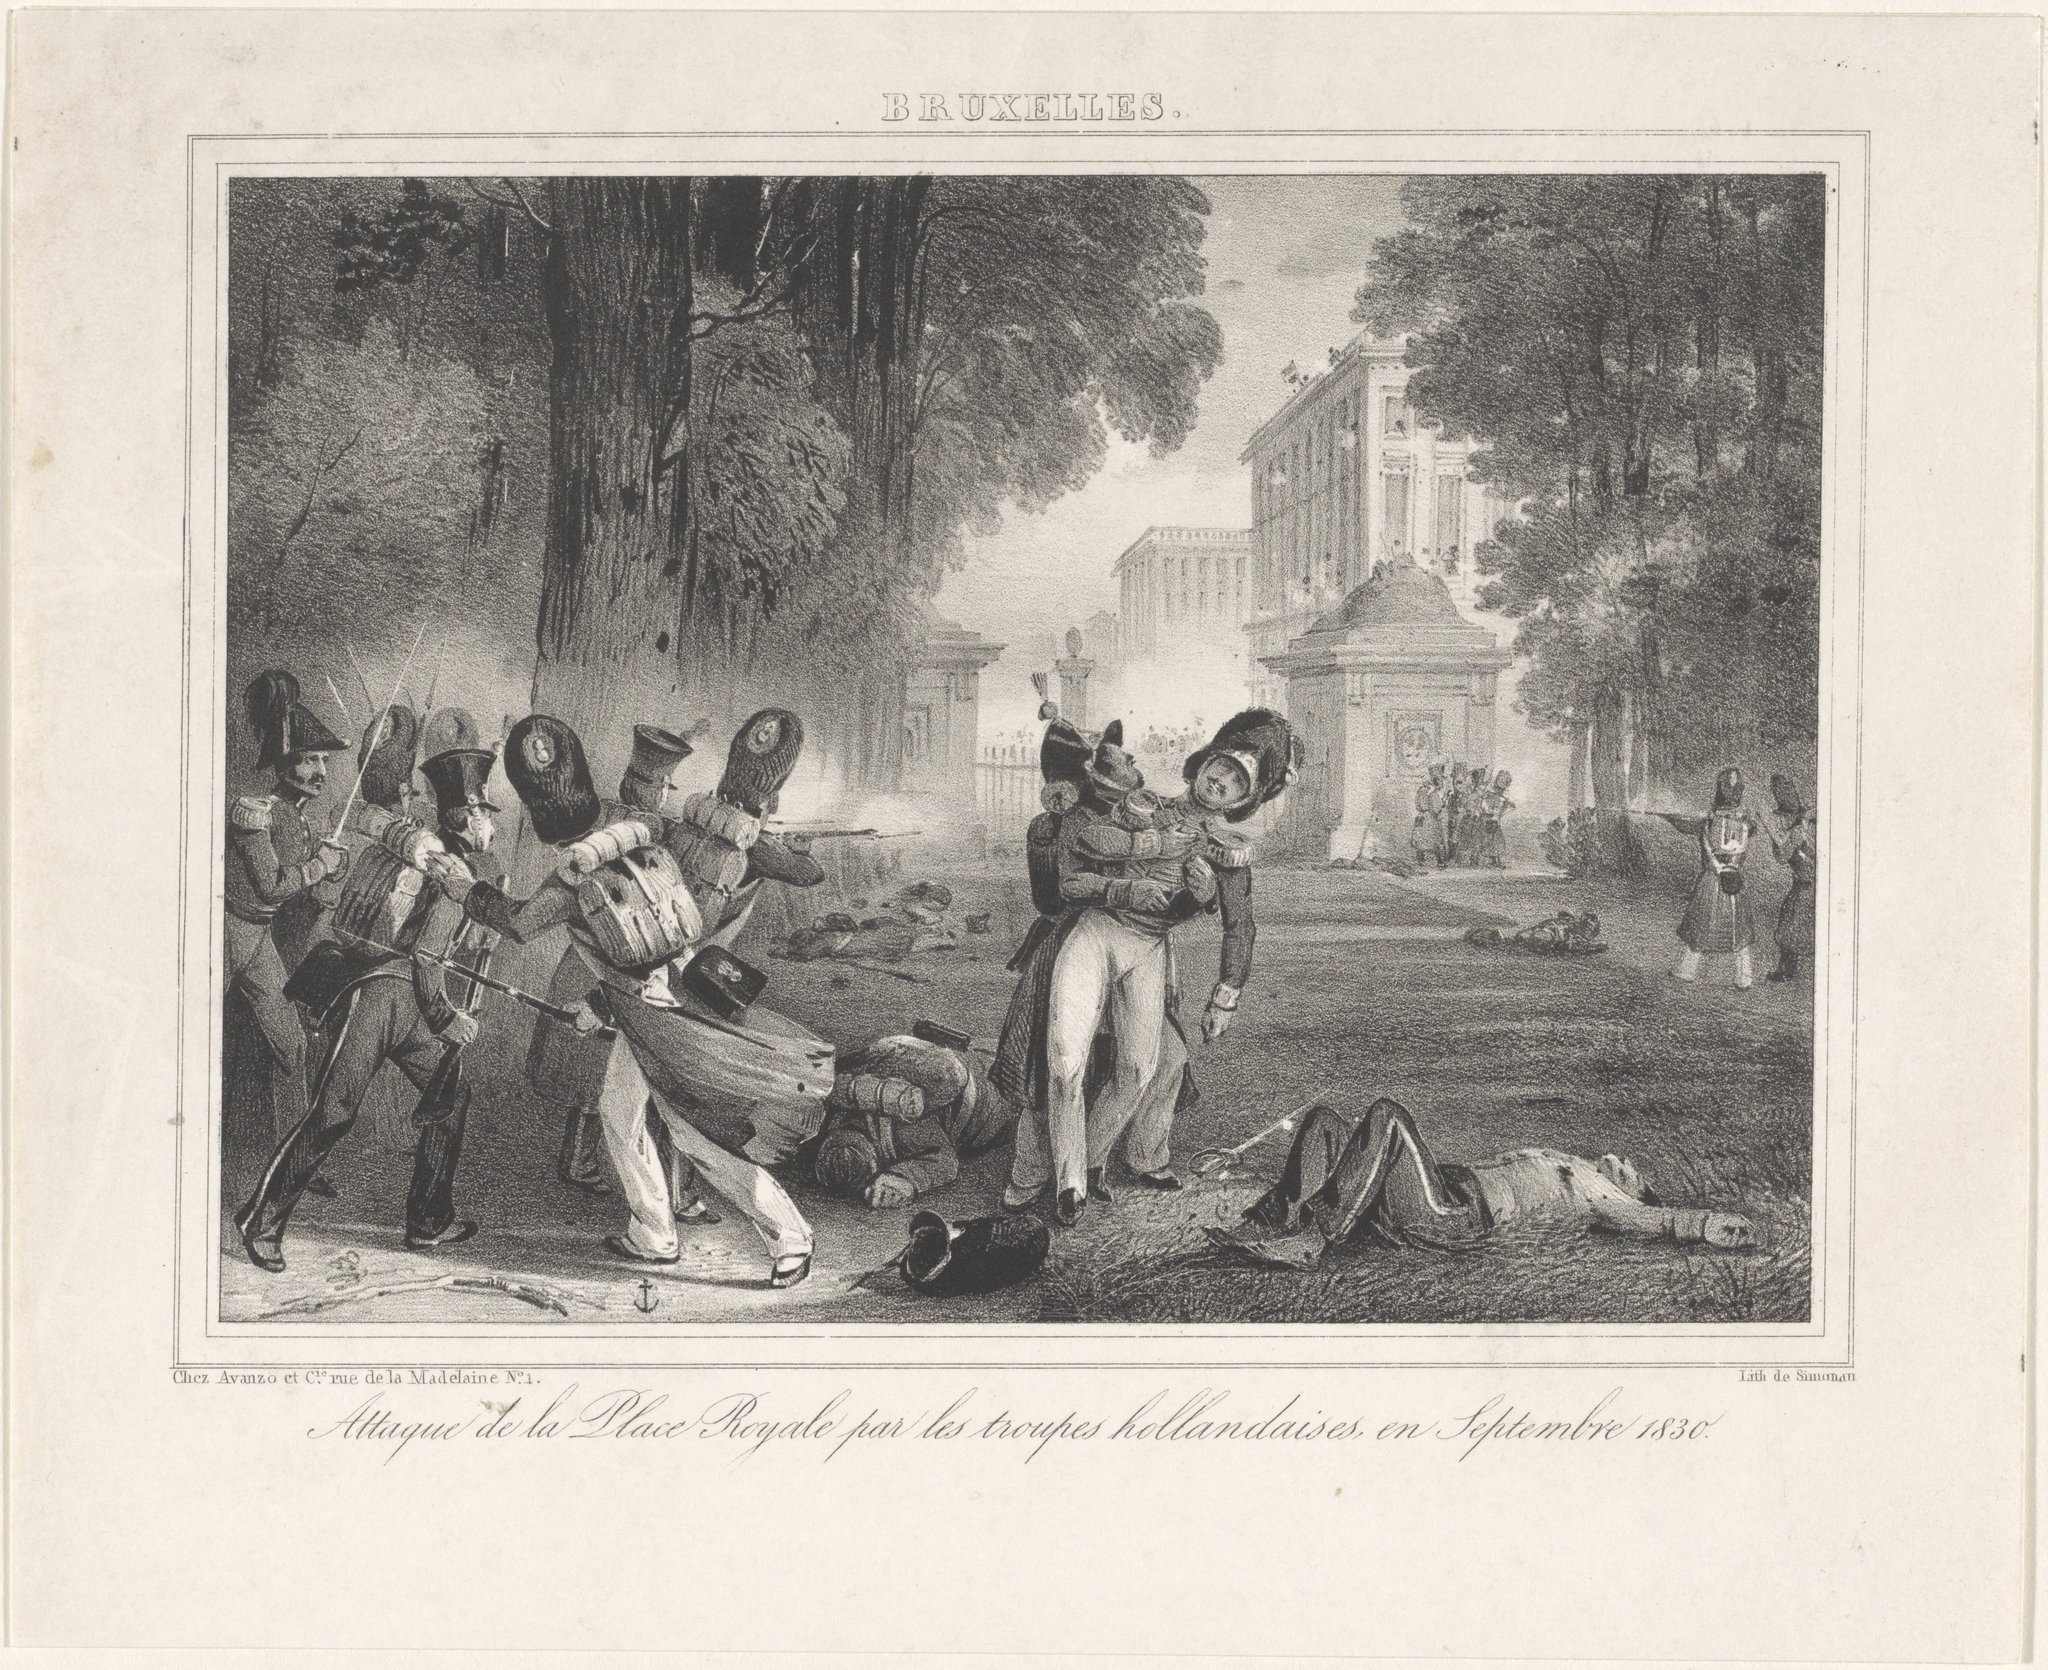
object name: print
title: Prenten toegevoegd aan de serie Evénemens de Bruxelles, Anvers (...) (1831)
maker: pierre simonau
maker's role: printer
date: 1830-1831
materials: paper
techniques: lithograph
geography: brussels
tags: street-fights, riots, brussels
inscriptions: collector's mark: Lugt 2228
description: Gevechten tussen de Nederlandse troepen en de Belgische opstandelingen bij de Place Royal in Brussel, september 1830. Centraal wordt een gewonde militair door een kameraad ondersteund. Onderdeel van een groep van prenten uit verschillende andere series verwant aan de platen in het recueil over de gebeurtenissen tijdens de Belgische Revolutie in Brussel, Antwerpen en andere steden in de periode 25 augustus 1830 tot 27 maart 1831.